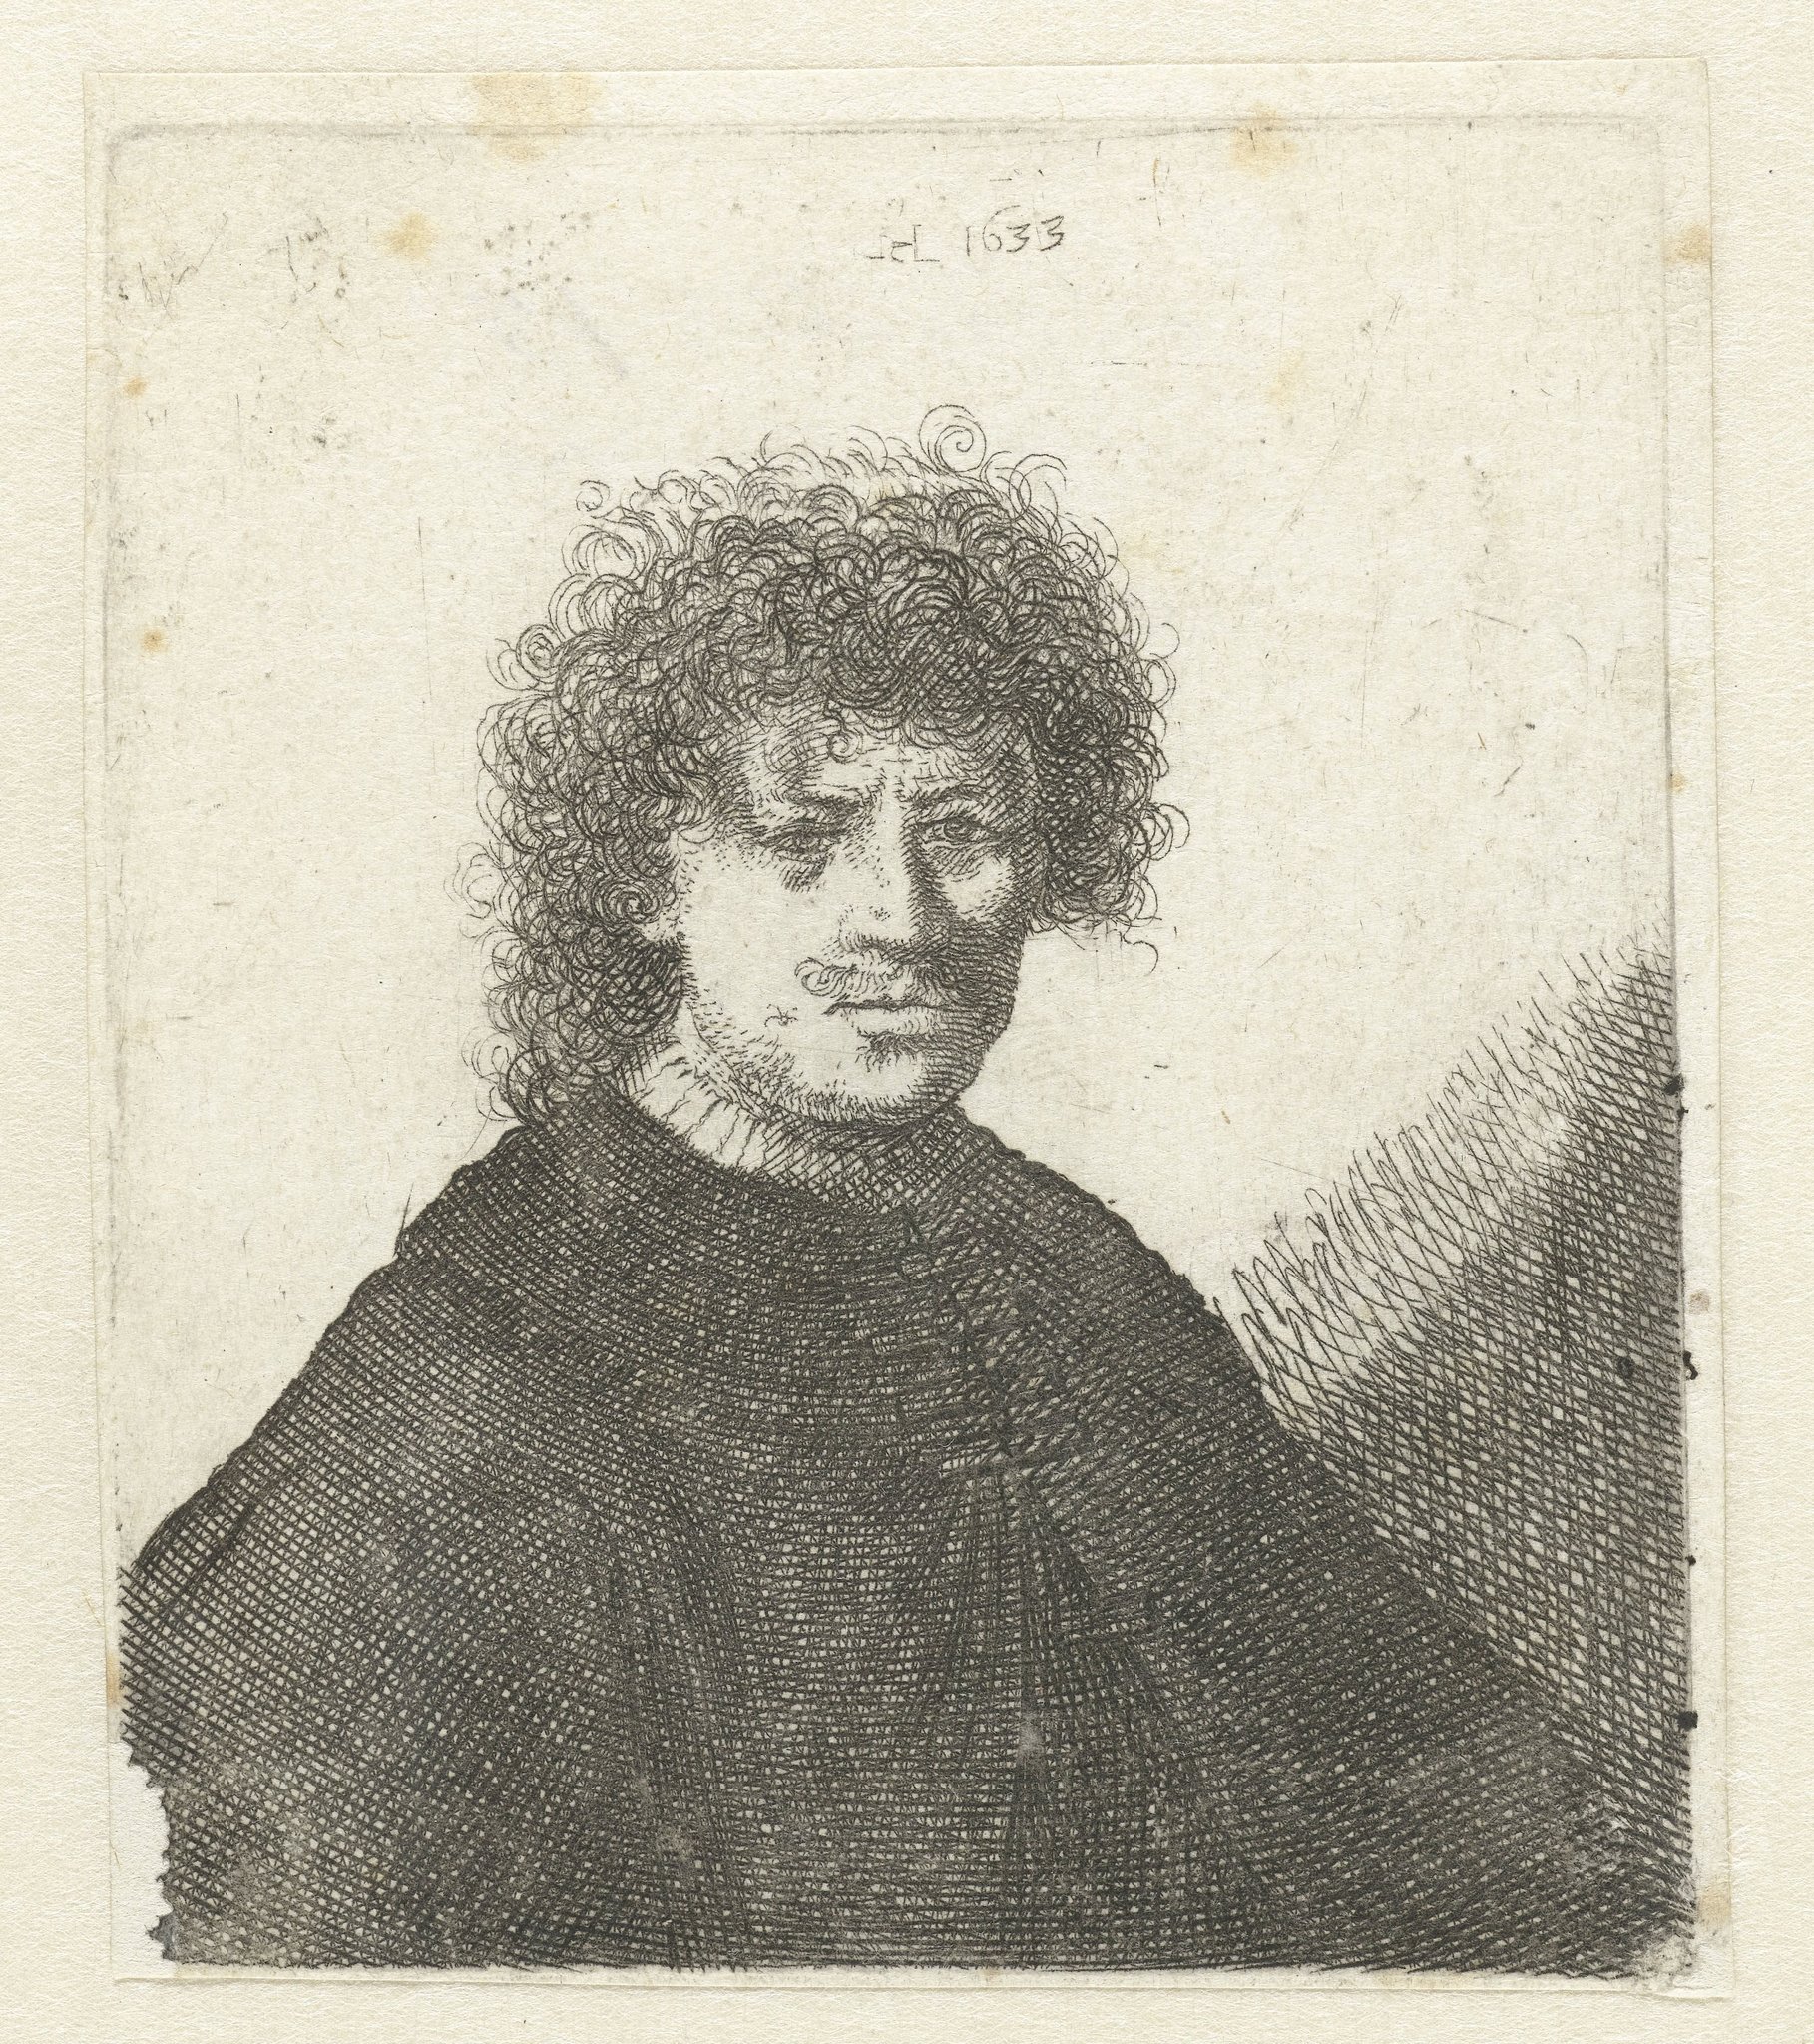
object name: print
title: Self-portrait in a cloak with a falling collar: bust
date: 1633-1656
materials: paper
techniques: drypoint, etching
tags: leiden, amsterdam, painter, print maker, draughtsman, rembrandt van rijn, portrait, self-portrait of graphic artist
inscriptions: collector's mark: Lugt 2228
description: Spiegelbeeldige kopie naar de gelijknamige prent van Rembrandt.